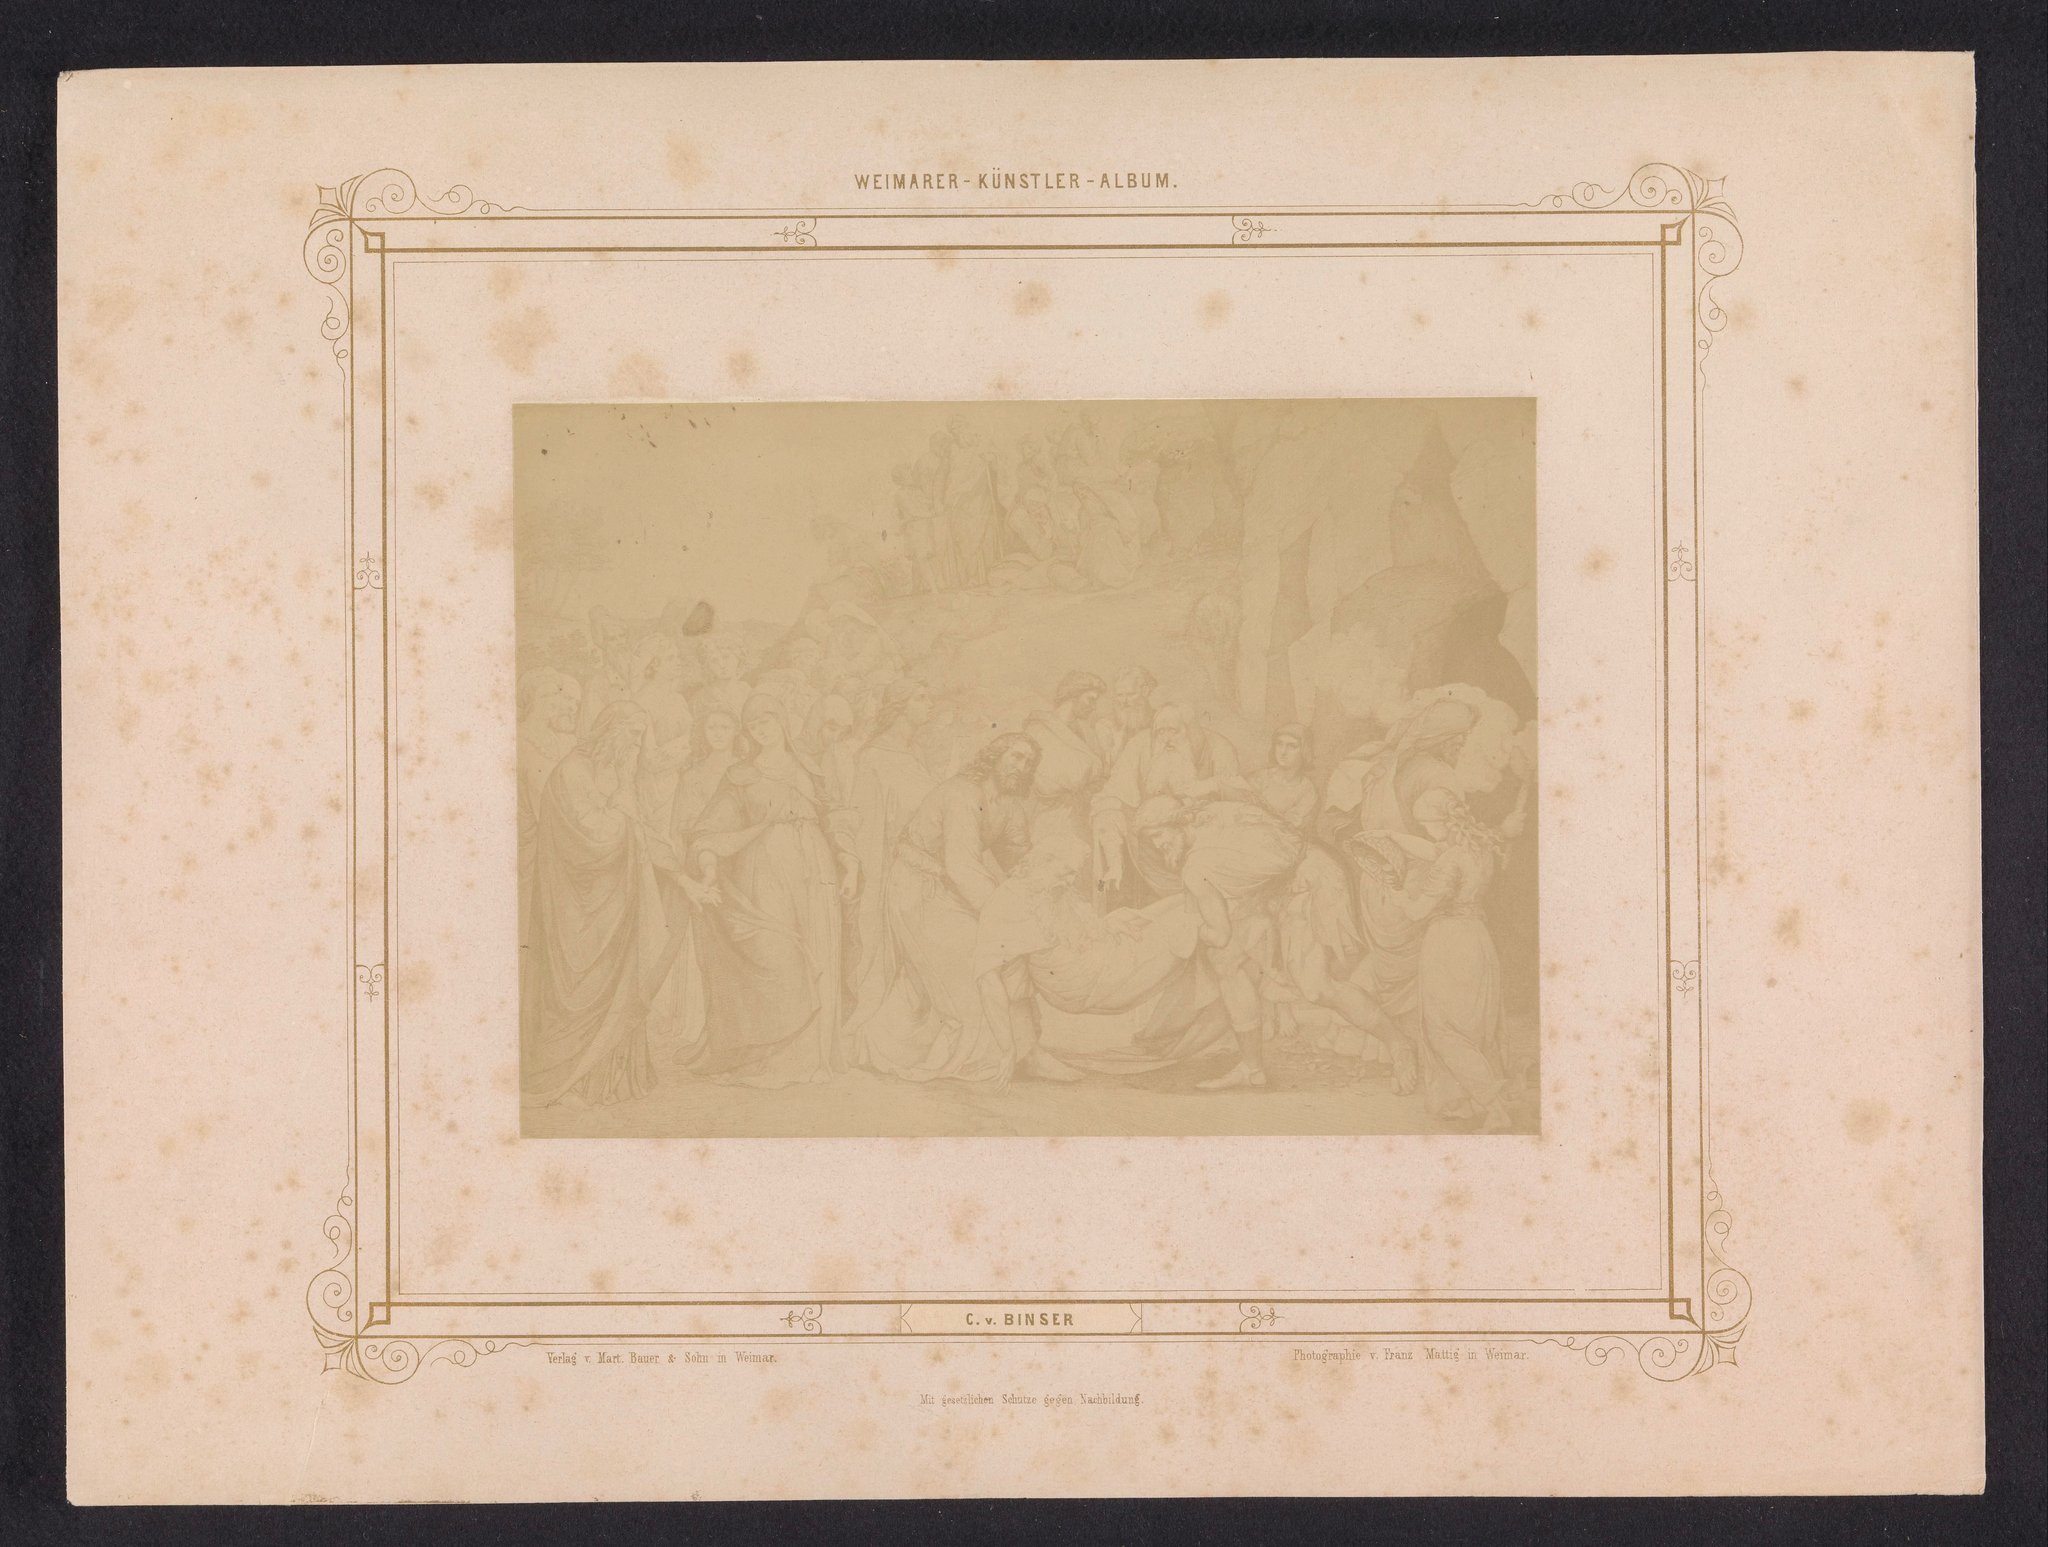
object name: reproduction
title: Fotoreproductie van een tekening, voorstellende de graflegging van Christus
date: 1854-1859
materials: photographic support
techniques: albumen print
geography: weimar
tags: bearing of christ's body to the grave